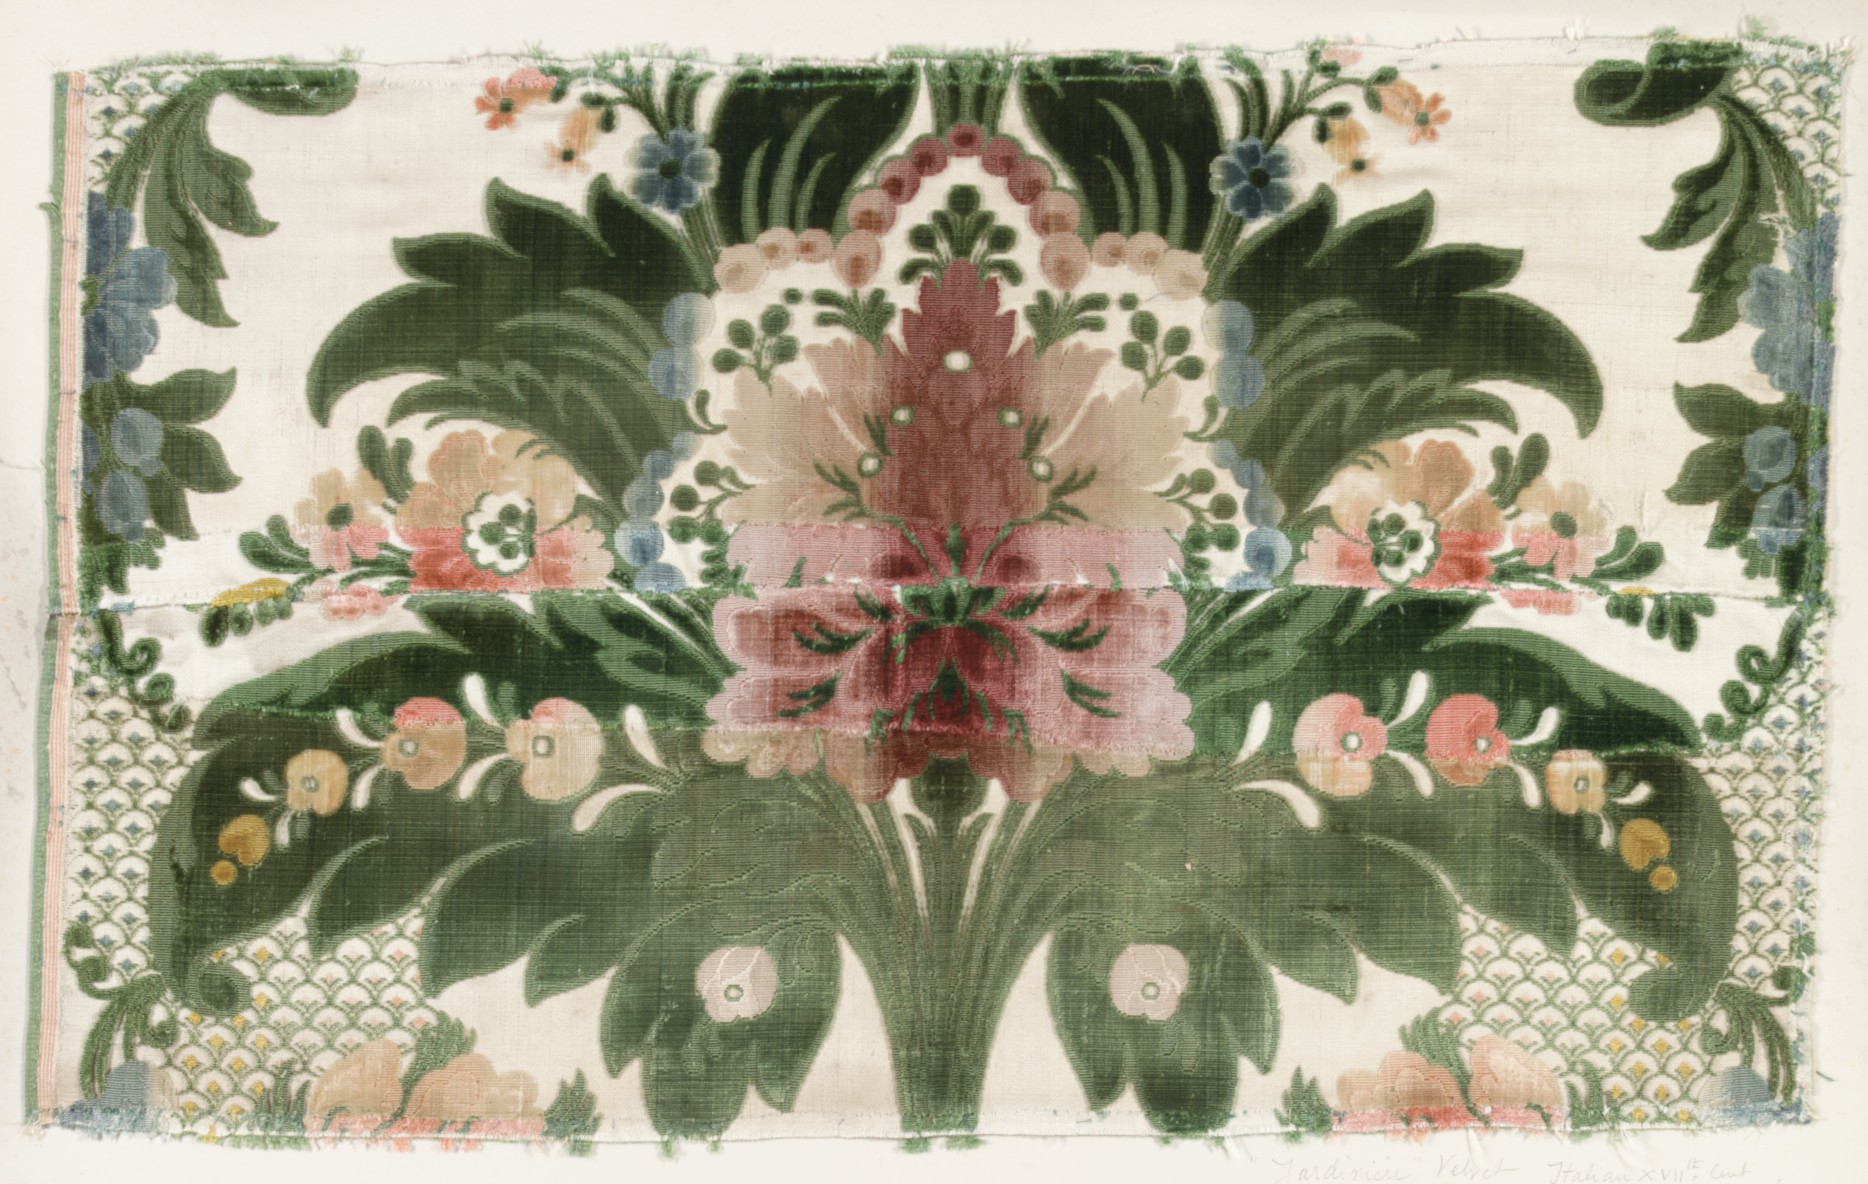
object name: fragment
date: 1601-1700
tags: flowers,leaves